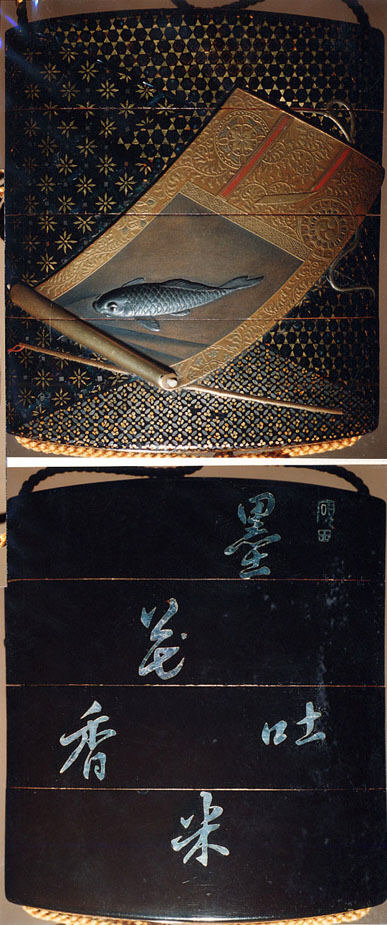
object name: inrō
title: Inrō with Carp Hanging Scroll and Characters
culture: japanese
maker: kōami chōkō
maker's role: artist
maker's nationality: japanese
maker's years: 1750-1799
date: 1751-1800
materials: stone, gold, gold foil, mother of pearl, silver, wood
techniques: cutting, hiramakie, inlay, lacquer, maki-e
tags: fish